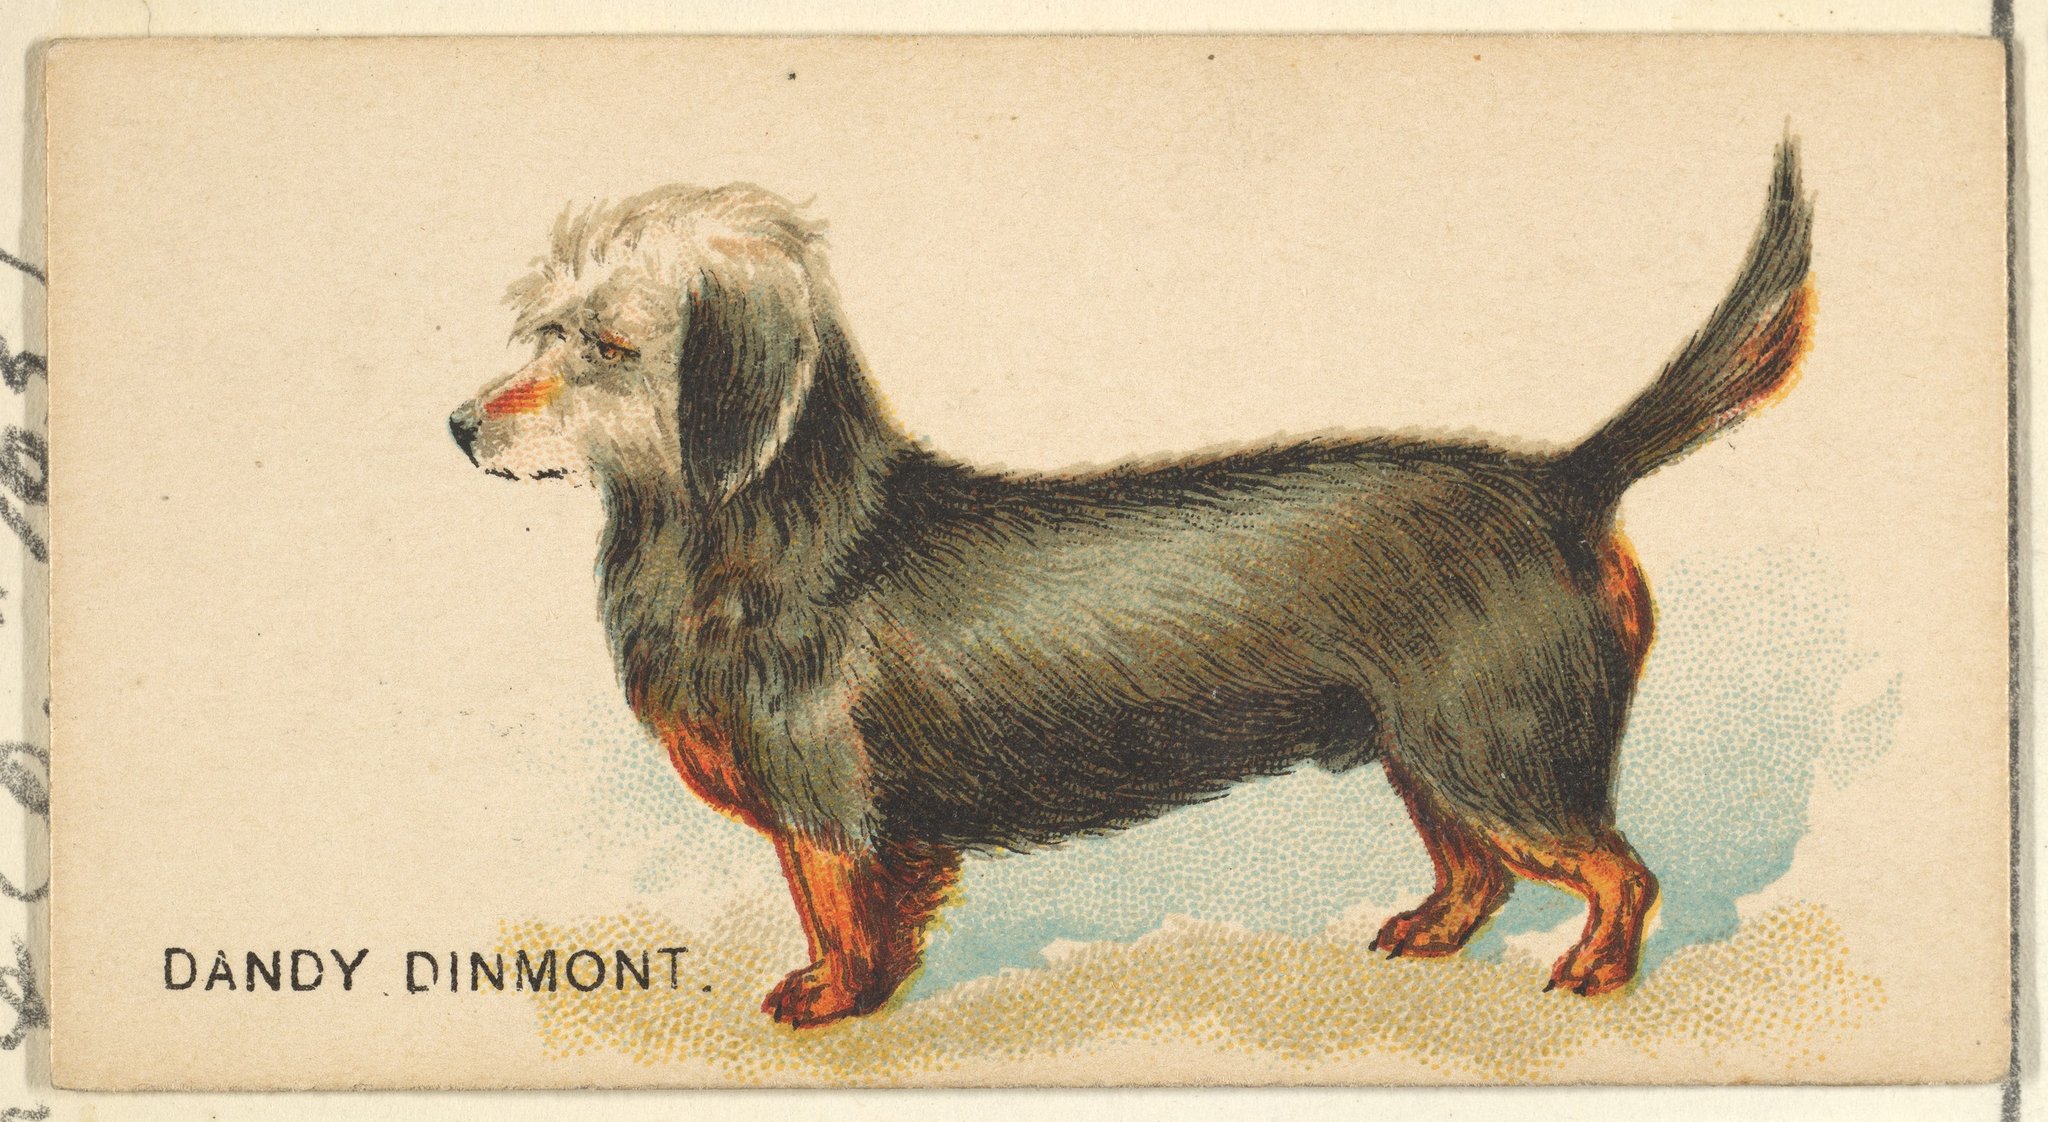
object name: print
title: Dandy Dinmont, from the Dogs of the World series for Old Judge Cigarettes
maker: goodwin & company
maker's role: publisher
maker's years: 1850-1950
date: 1890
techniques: color lithograph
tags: dogs